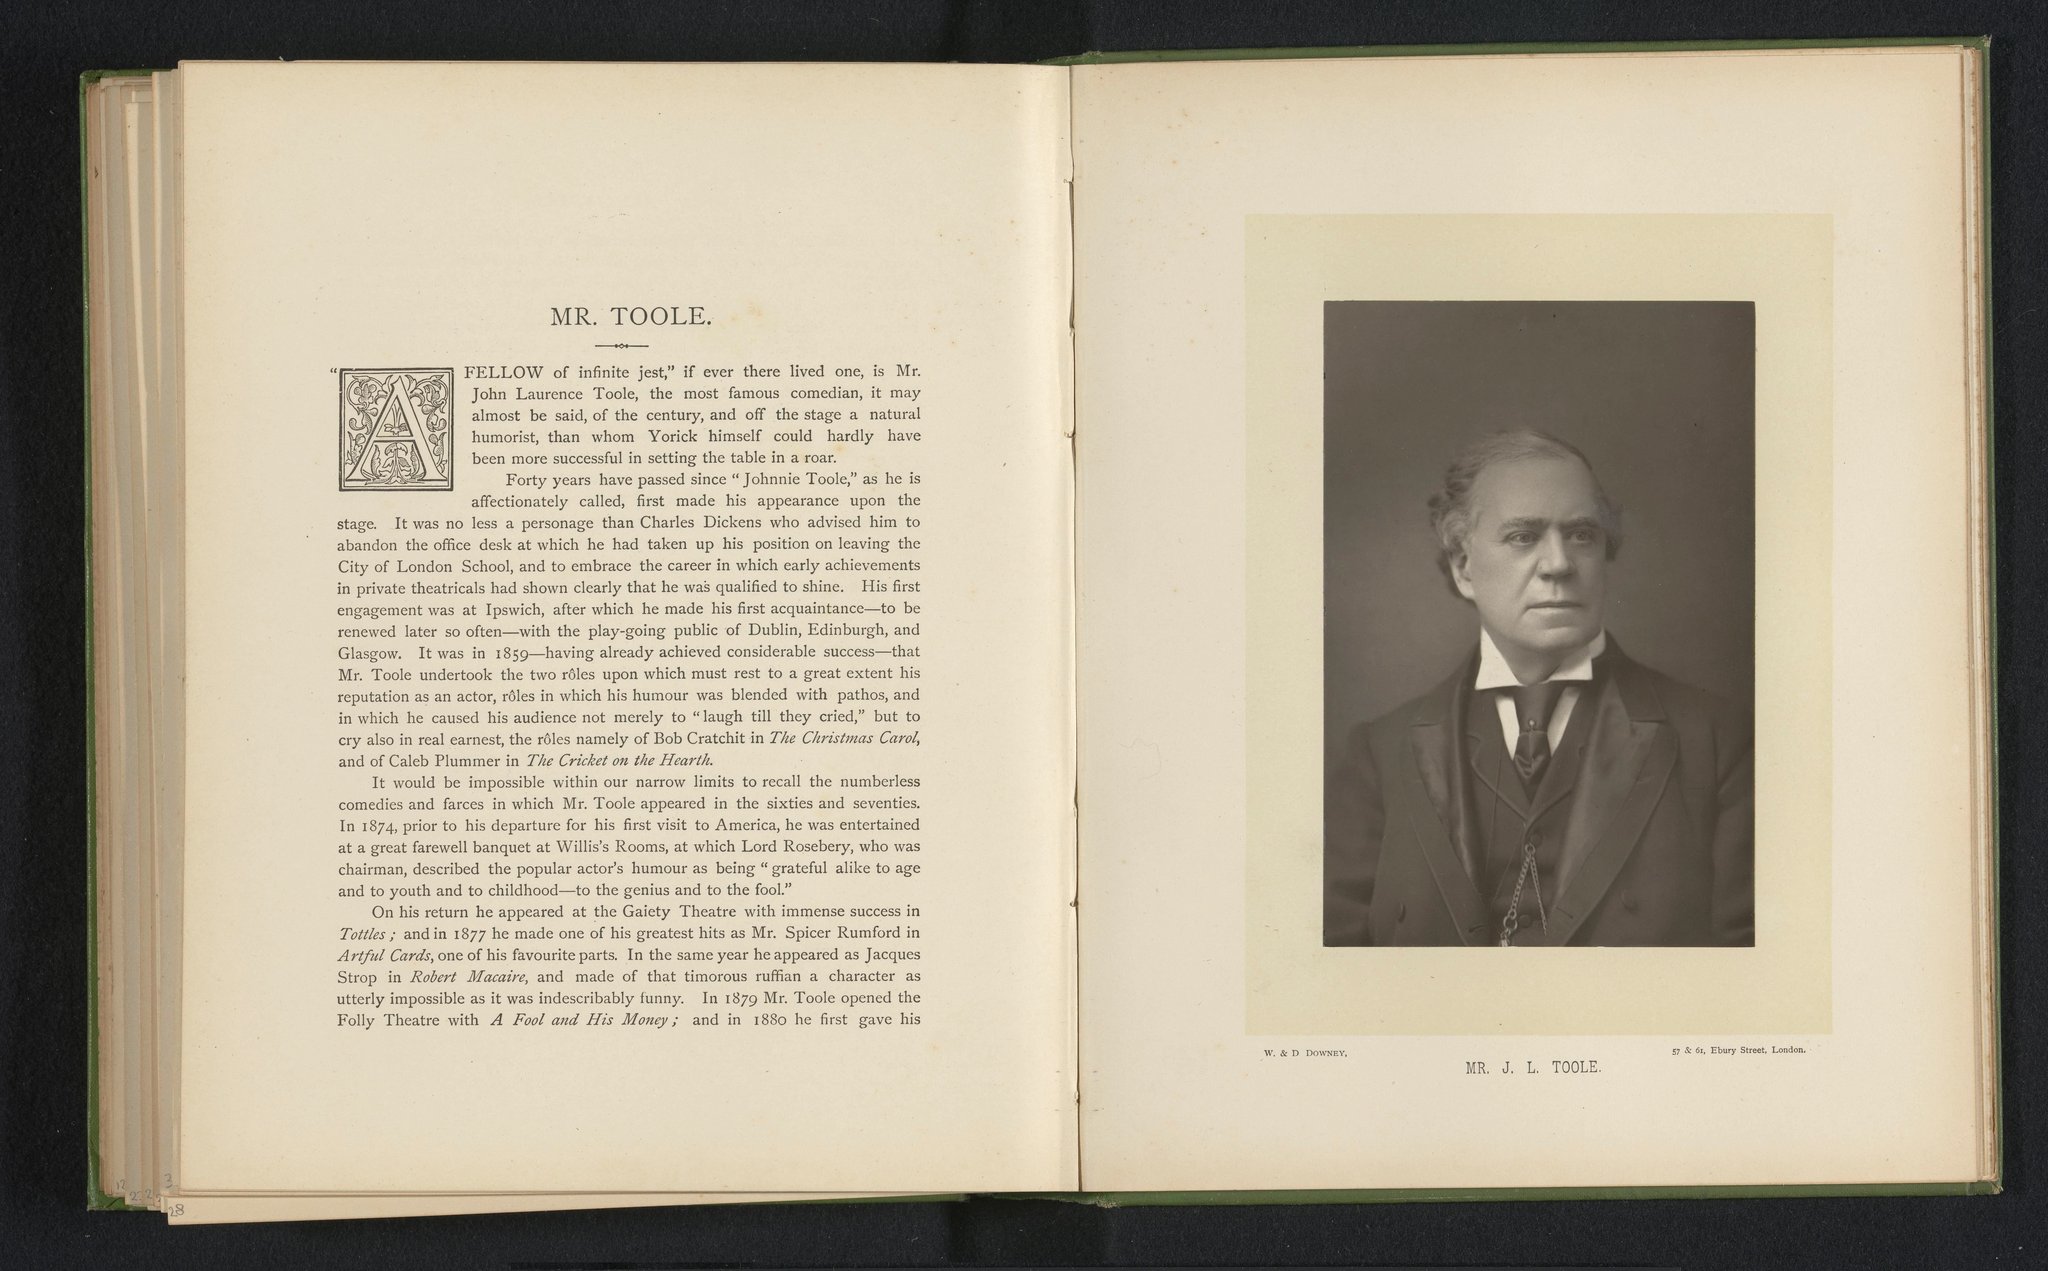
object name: photomechanical print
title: Mr. J.L. Toole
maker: Anonymous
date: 1884-1894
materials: paper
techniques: woodburytype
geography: london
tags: portrait of actor, actress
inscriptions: inscription: ‘57 & 61, Elbury Street, London.’